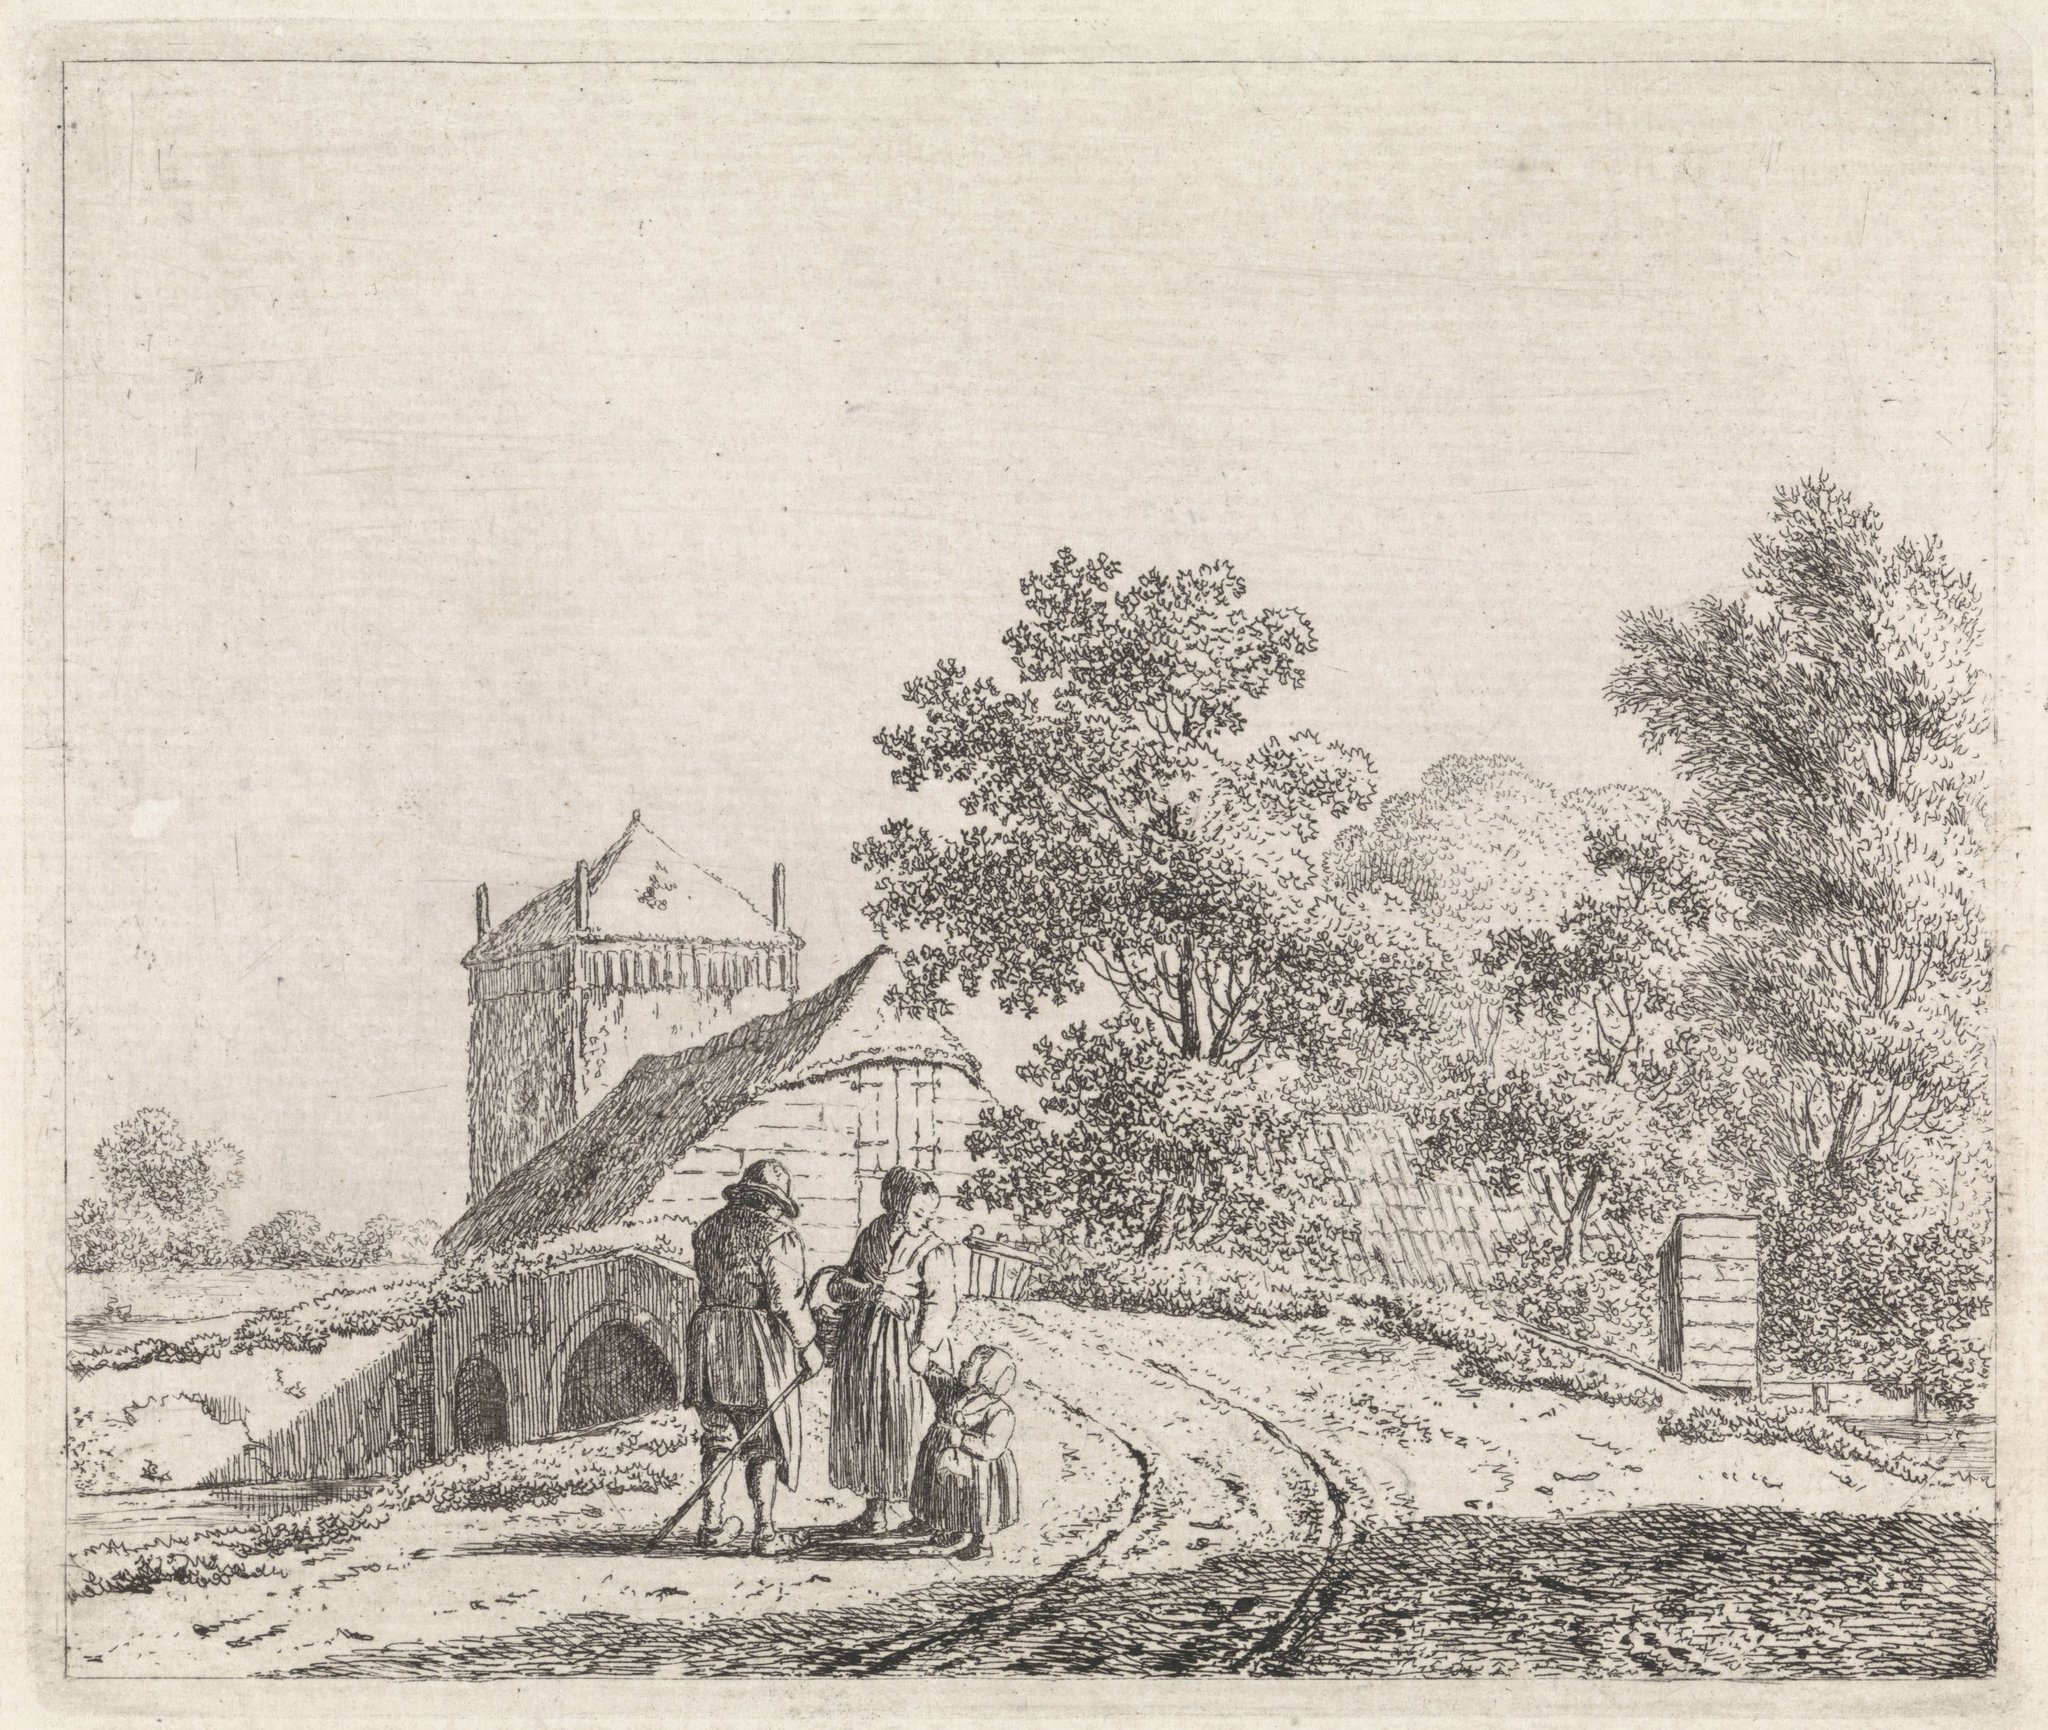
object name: print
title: Landschap met stenen brug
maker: johannes christiaan janson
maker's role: draughtsman, painter, print maker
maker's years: 1763-1823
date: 1778-1823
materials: paper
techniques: etching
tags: landscape with bridge, viaduct or aqueduct, mother and baby or young child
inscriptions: collector's mark: Lugt 2228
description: Landschap met stenen brug met op de voorgrond een man, op de rug gezien, en een vrouw met kind. Op de achtergrond een boerderij met hooischuur. Vóór de lucht.